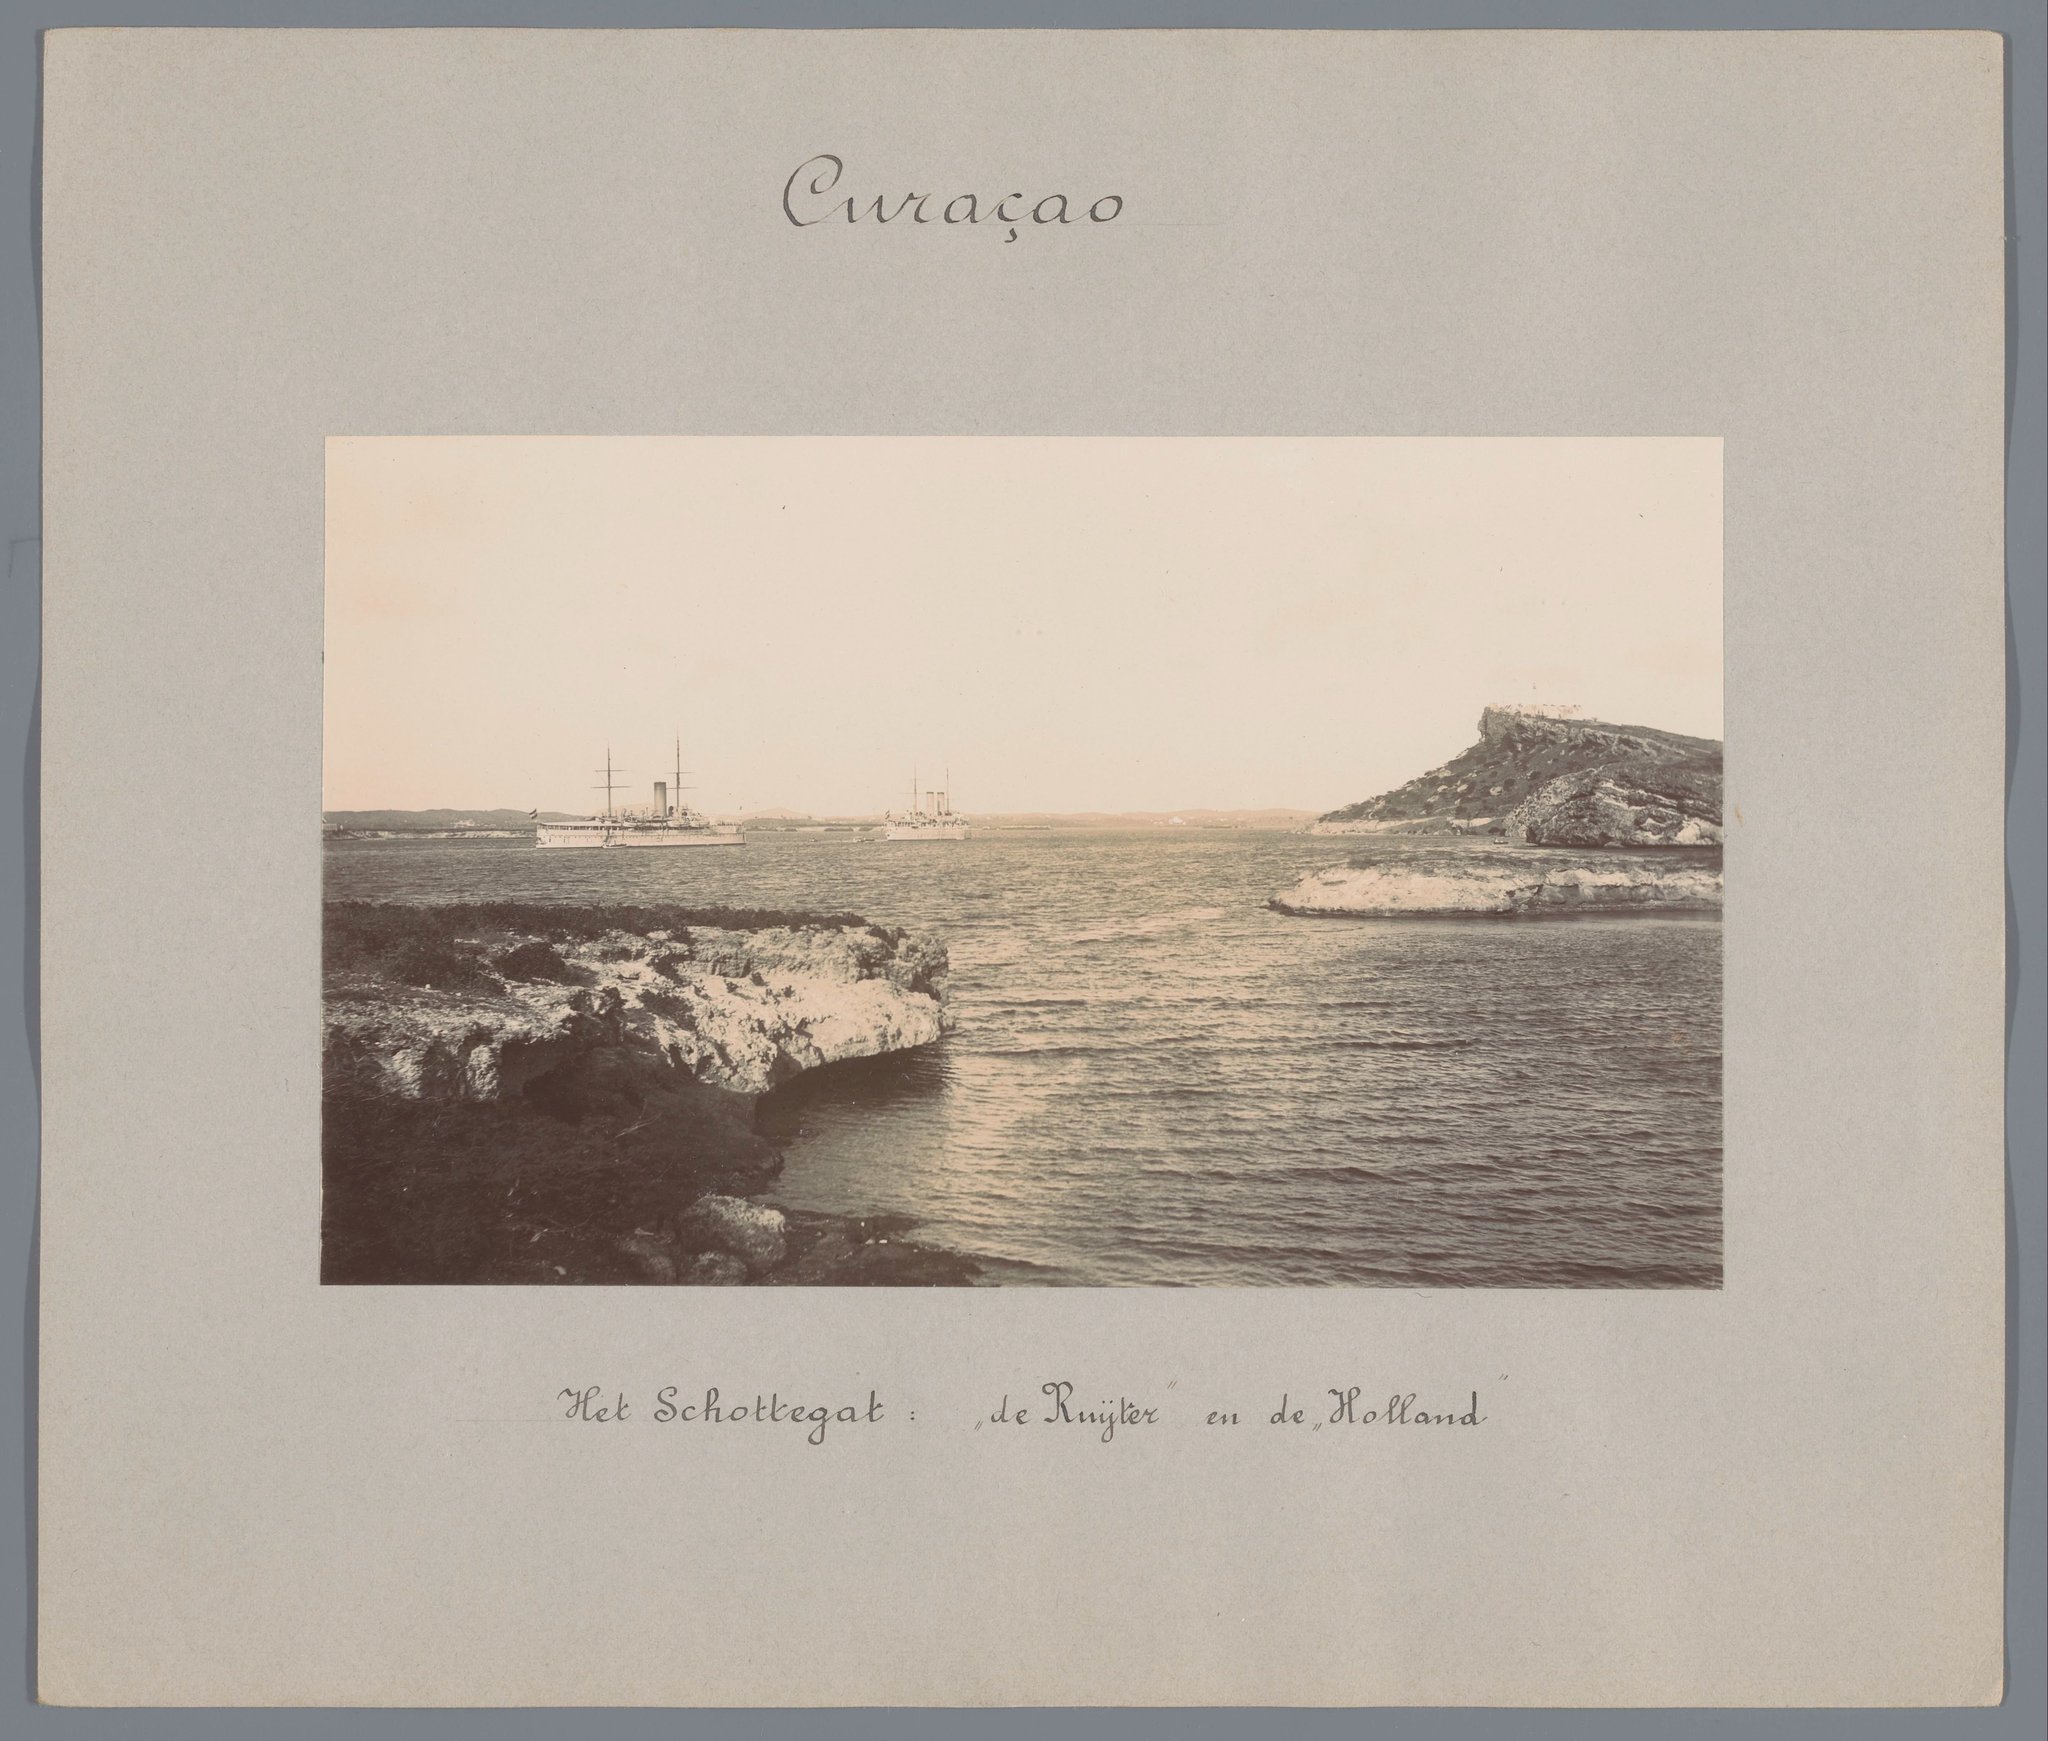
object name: photograph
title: Het Schottegat: "de Ruijter" en de "Holland"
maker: Anonymous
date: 1900-1905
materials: cardboard, photographic support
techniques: gelatin silver print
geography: willemstad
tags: willemstad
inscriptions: inscription: ‘Curaçao / Het Schottegat: "de Ruijter" en de "Holland"’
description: Gezicht op het Schottegat, de haven van Willemstad op Curaçao. Op het water liggen de stoomschepen "De Ruijter"en "Holland". Onderdeel van een groep van 44 foto's van Paramaribo, Suriname en Curaçao, ca. 1900-1905, opgeplakt op kartons en voorzien van opschriften.